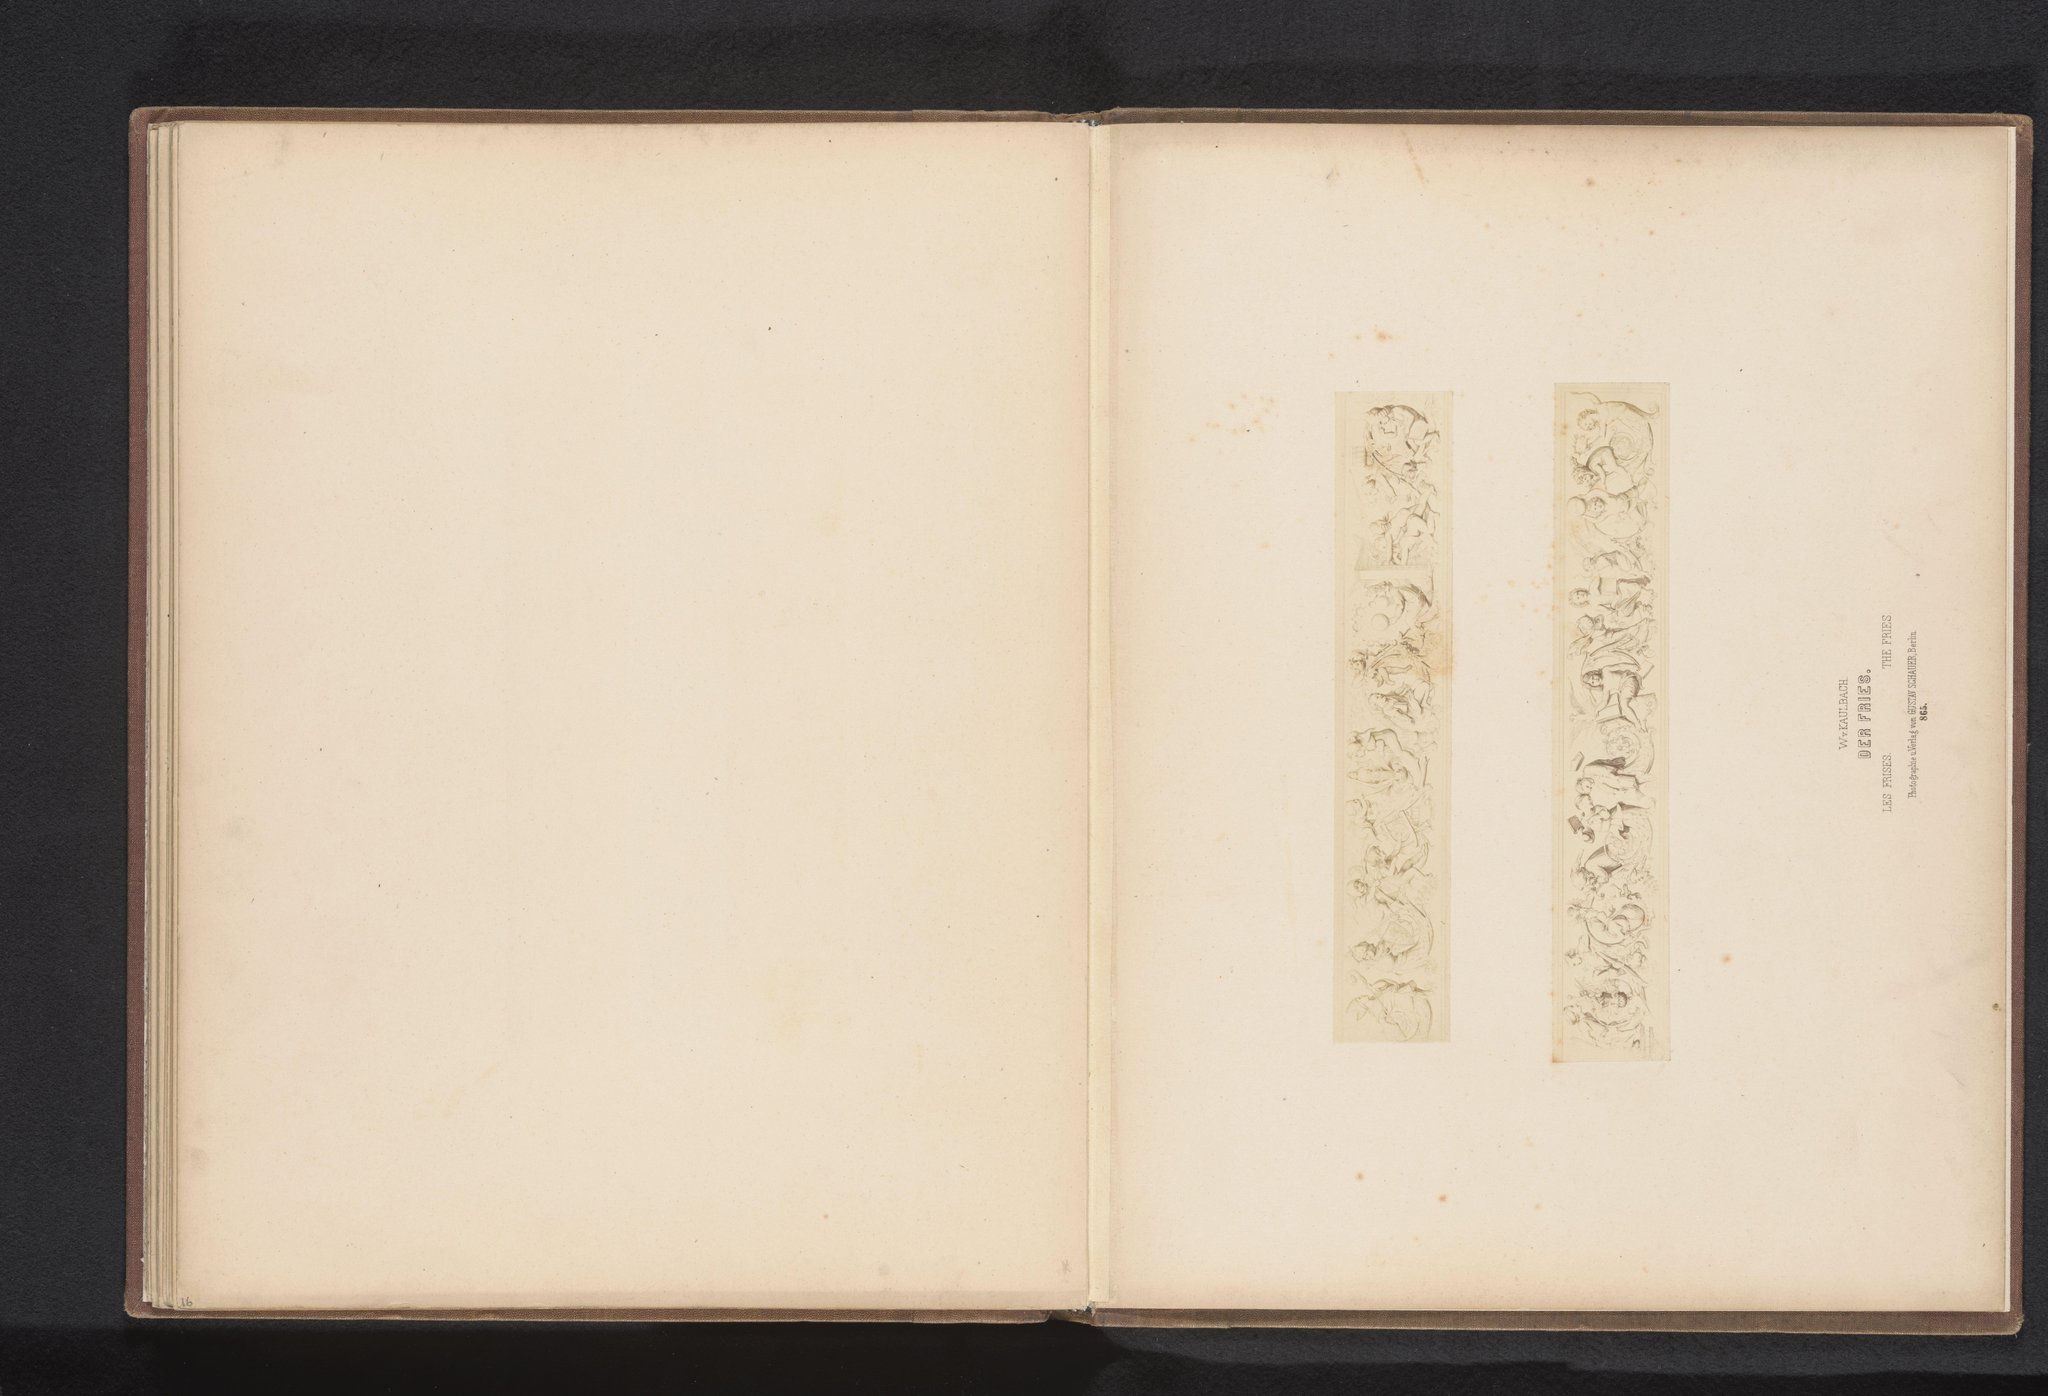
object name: photograph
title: Fotoreproducties van twee tekeningen voor decoratieve friezen voor wandschilderingen voor het trappenhuis van het Neues Museum in Berlijn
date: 1860-1870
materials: photographic support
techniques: albumen print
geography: berlin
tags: wall-covering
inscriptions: number: ‘865.’